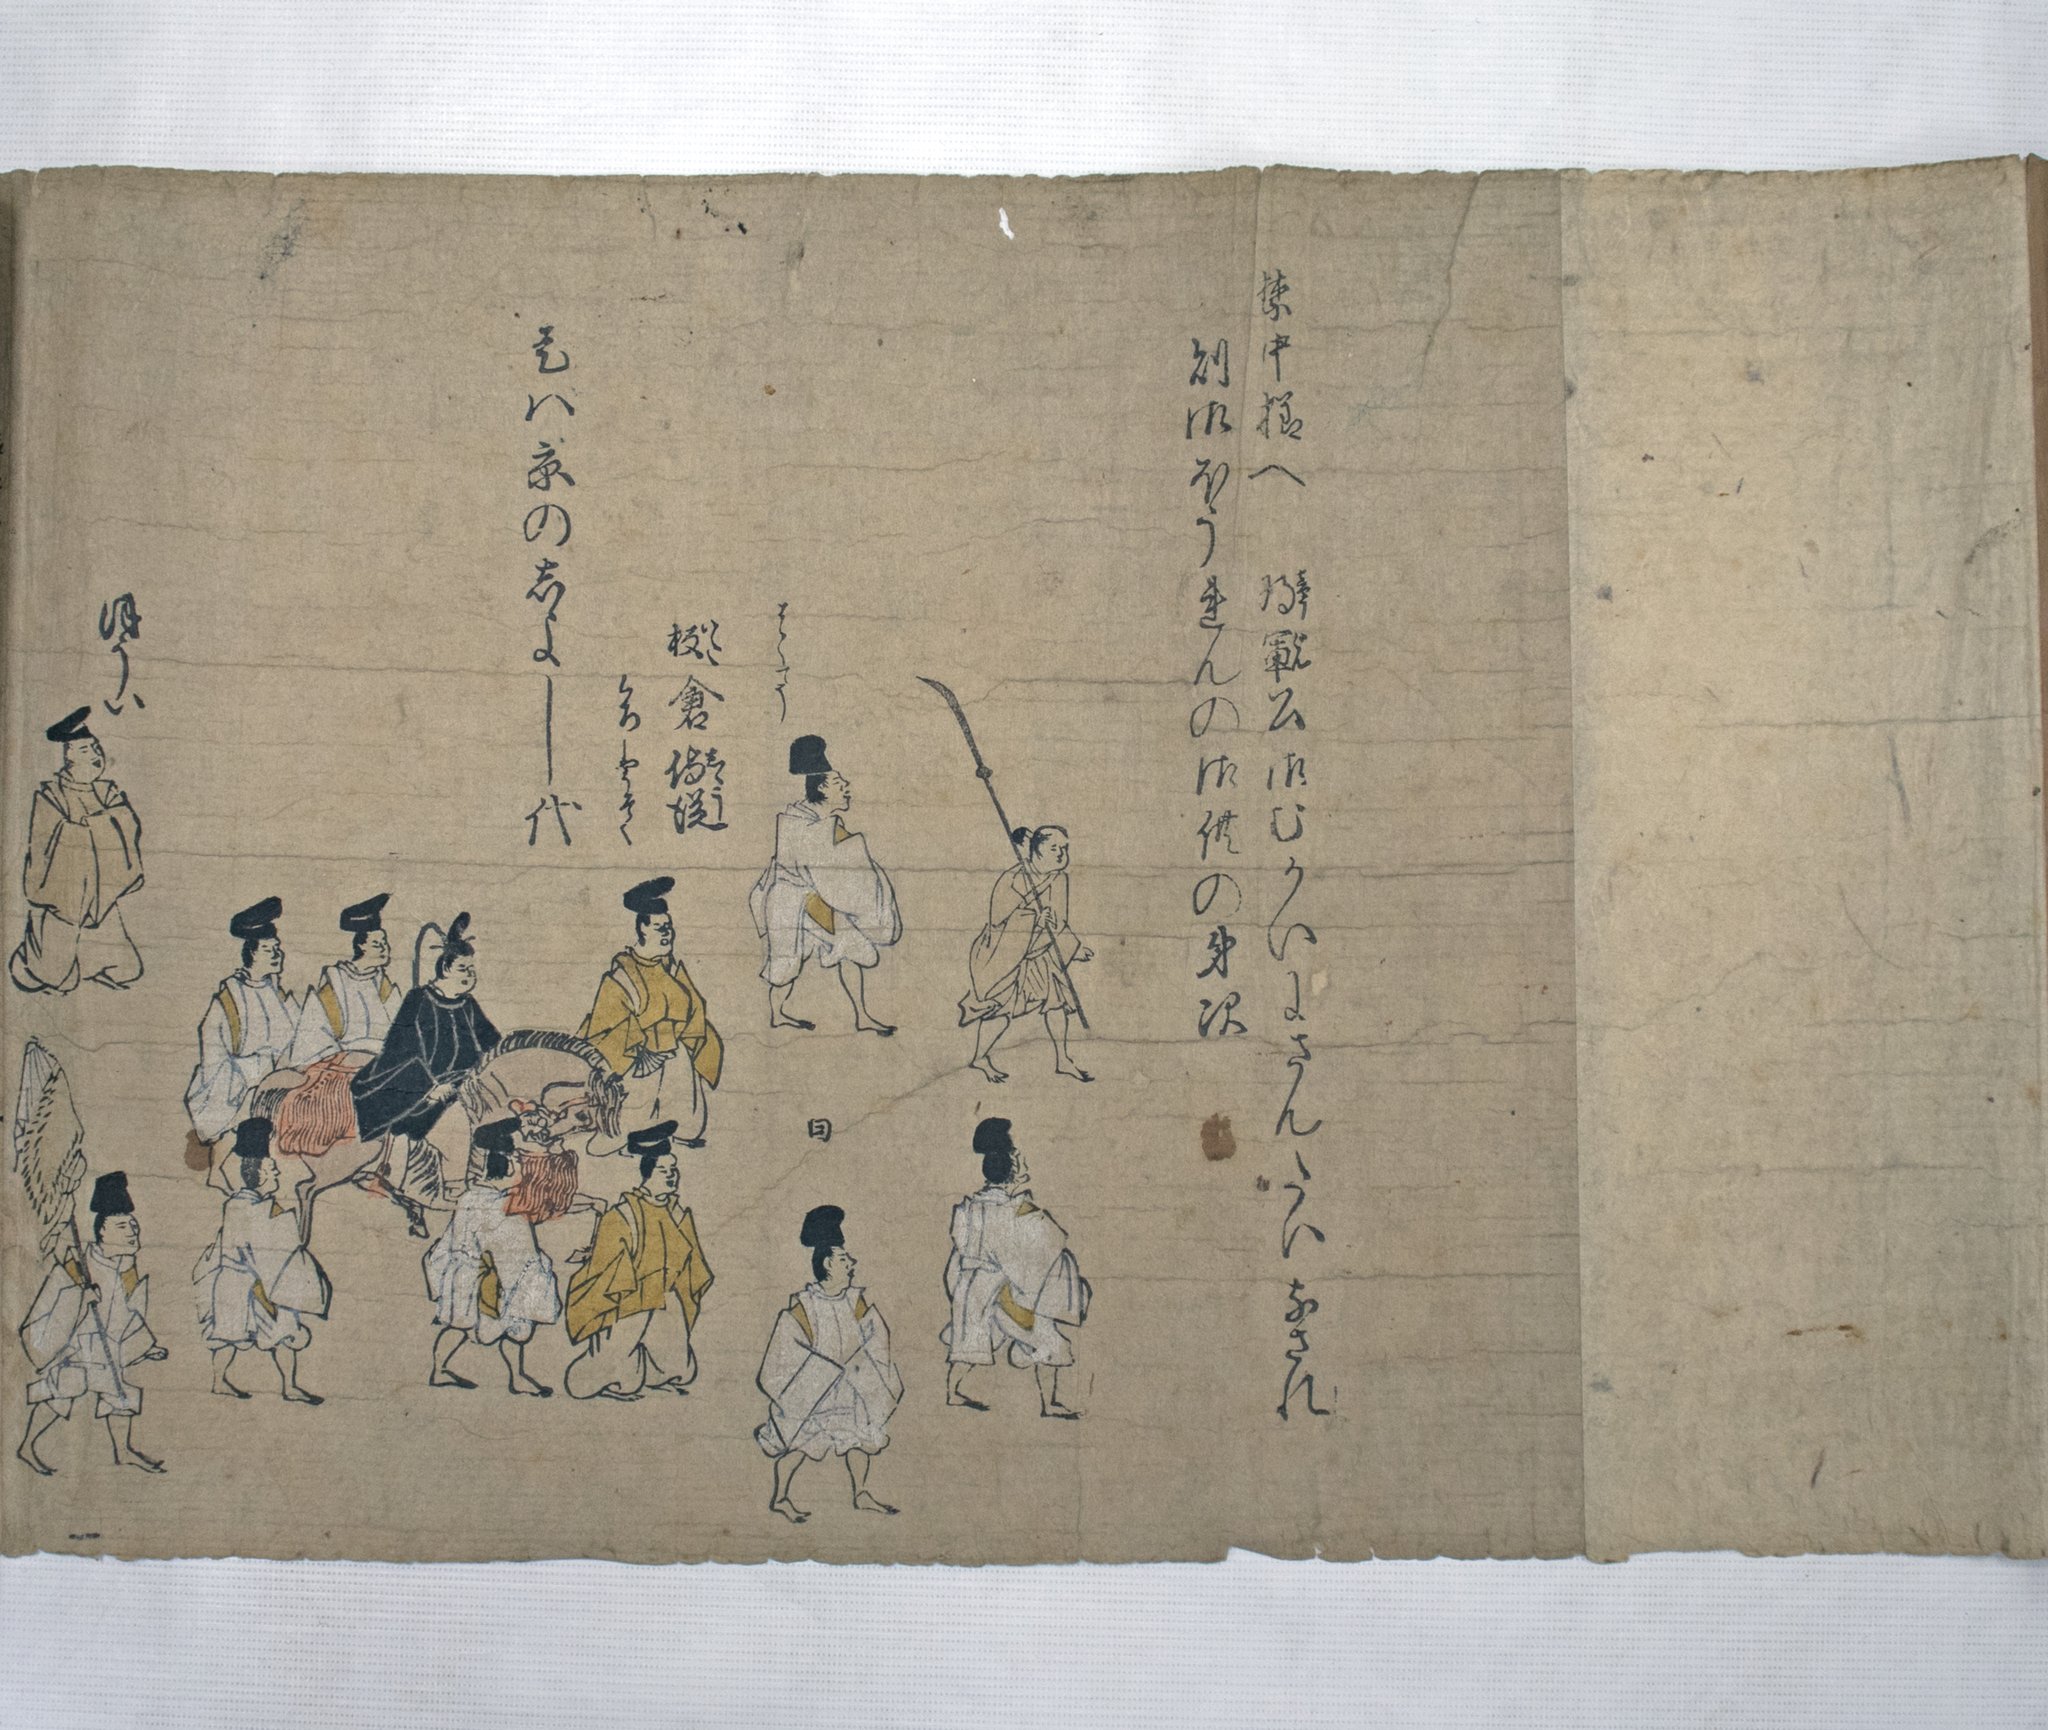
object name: printed scroll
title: Procession of the Emperor and Suite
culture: japanese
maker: kano school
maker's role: artist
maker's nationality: japanese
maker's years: 1476-1559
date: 1626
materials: ink, paper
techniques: tinting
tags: human figures,kings,carriages